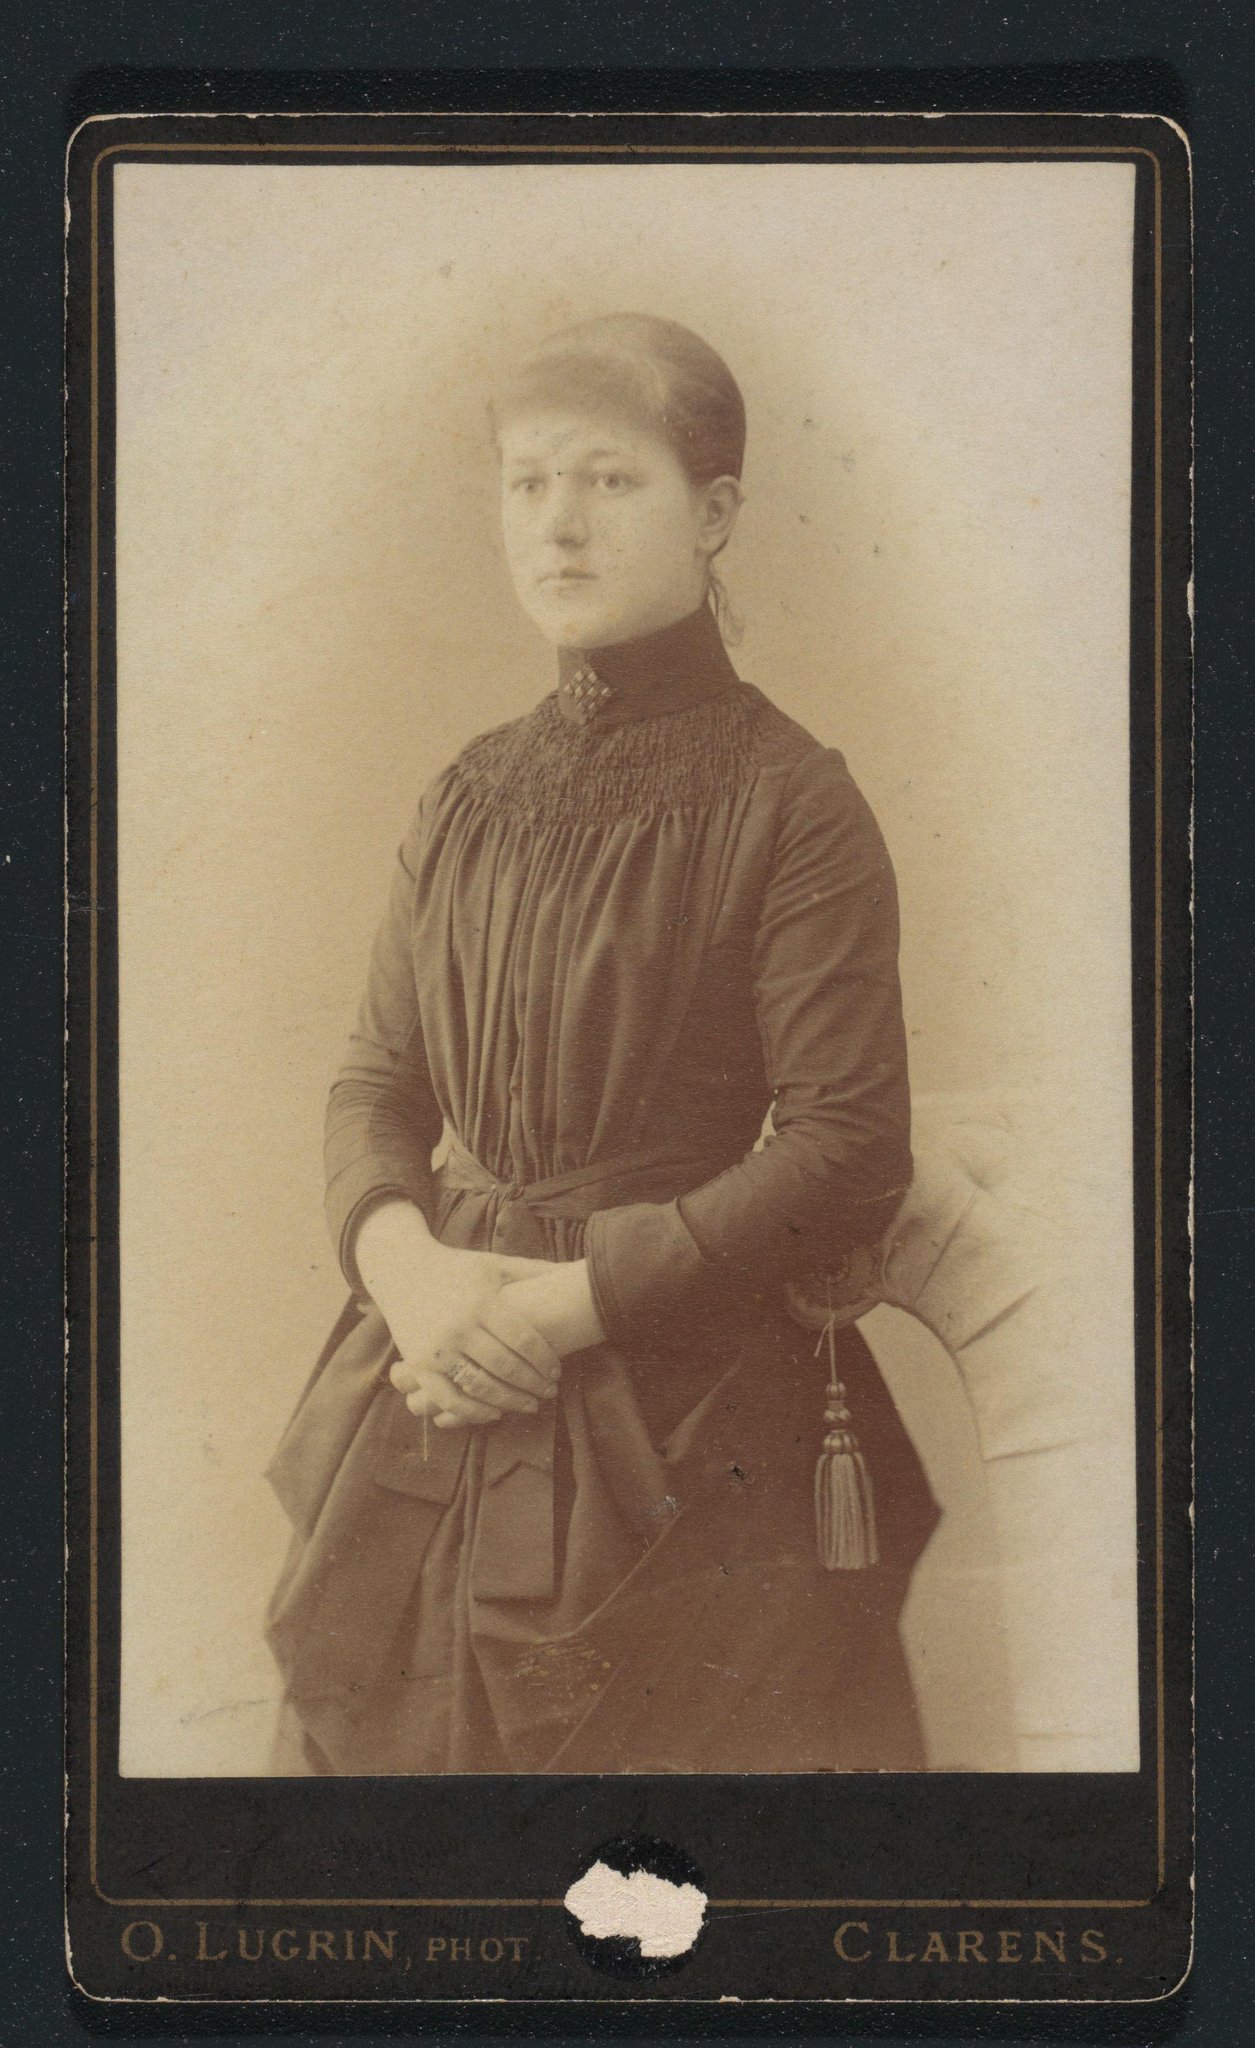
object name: carte de visite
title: Portret van [(...)] Elisabeth Bosch Reitz als jong meisje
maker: o. lugrin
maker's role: fotograaf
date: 1892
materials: cardboard, photographic support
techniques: albumen print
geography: clarens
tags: adolescent, young woman, maiden, dress, gown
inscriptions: inscription: ‘[...] Elisabeth Bosch Reitz 1892’, address: ‘Clarens’